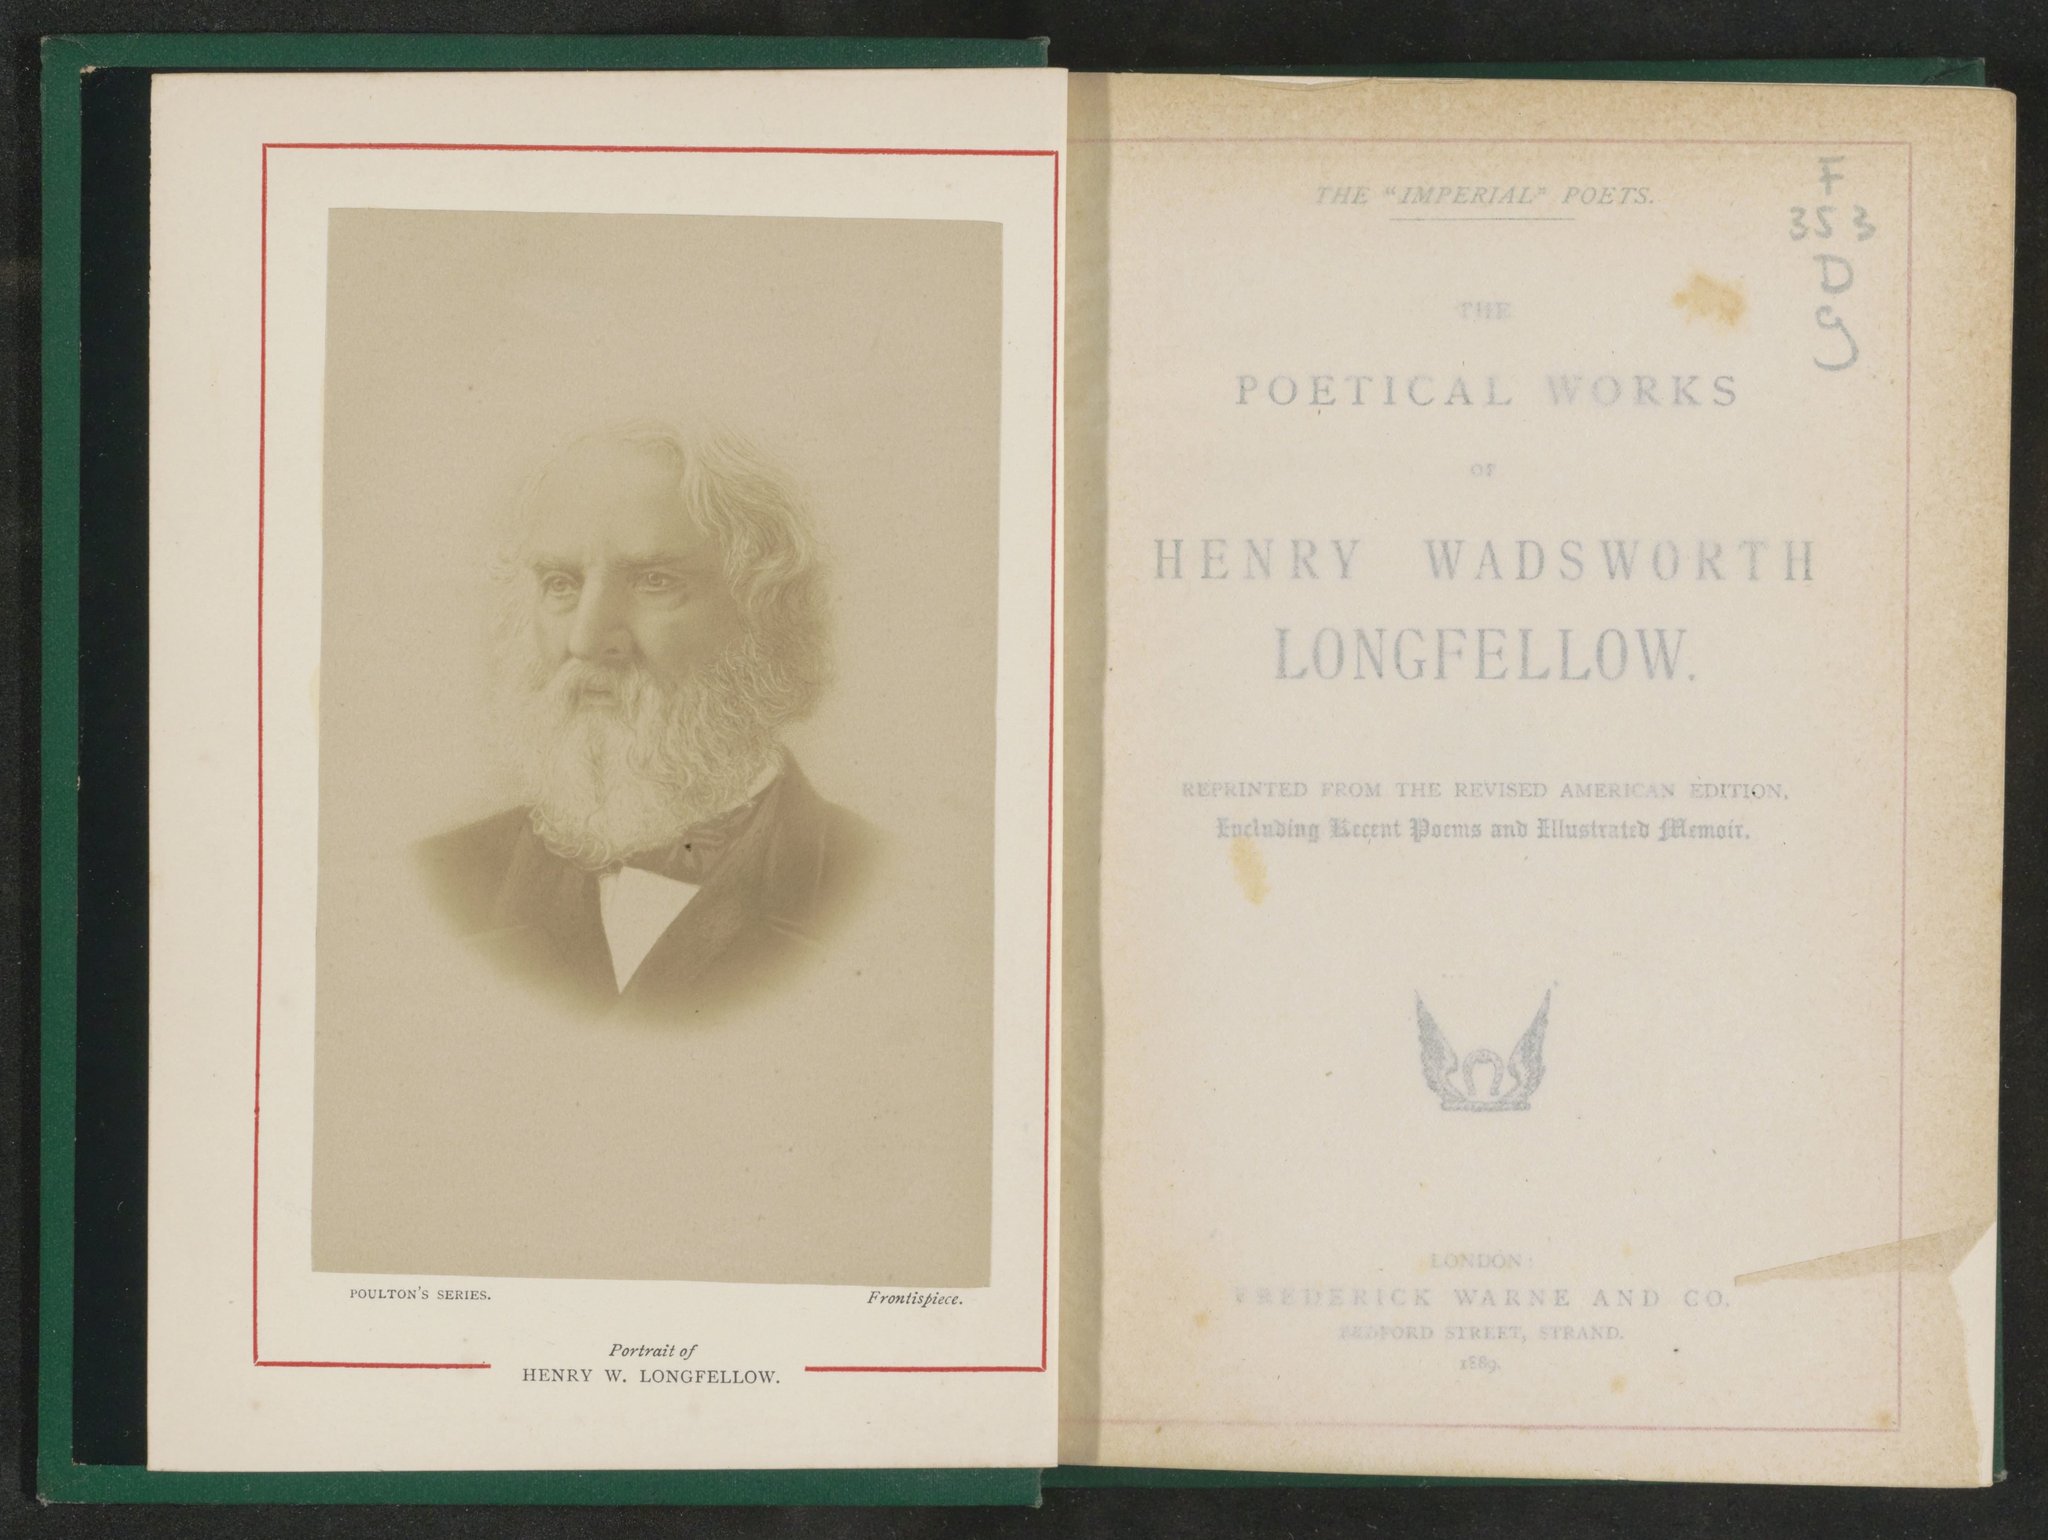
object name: page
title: Portret van Henry Wadsworth Longfellow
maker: Anonymous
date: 1879-1889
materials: photographic support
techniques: albumen print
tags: henry wadsworth longfellow, portrait, self-portrait of artist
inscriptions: inscription: ‘Poulton's Series. Frontispiece.’